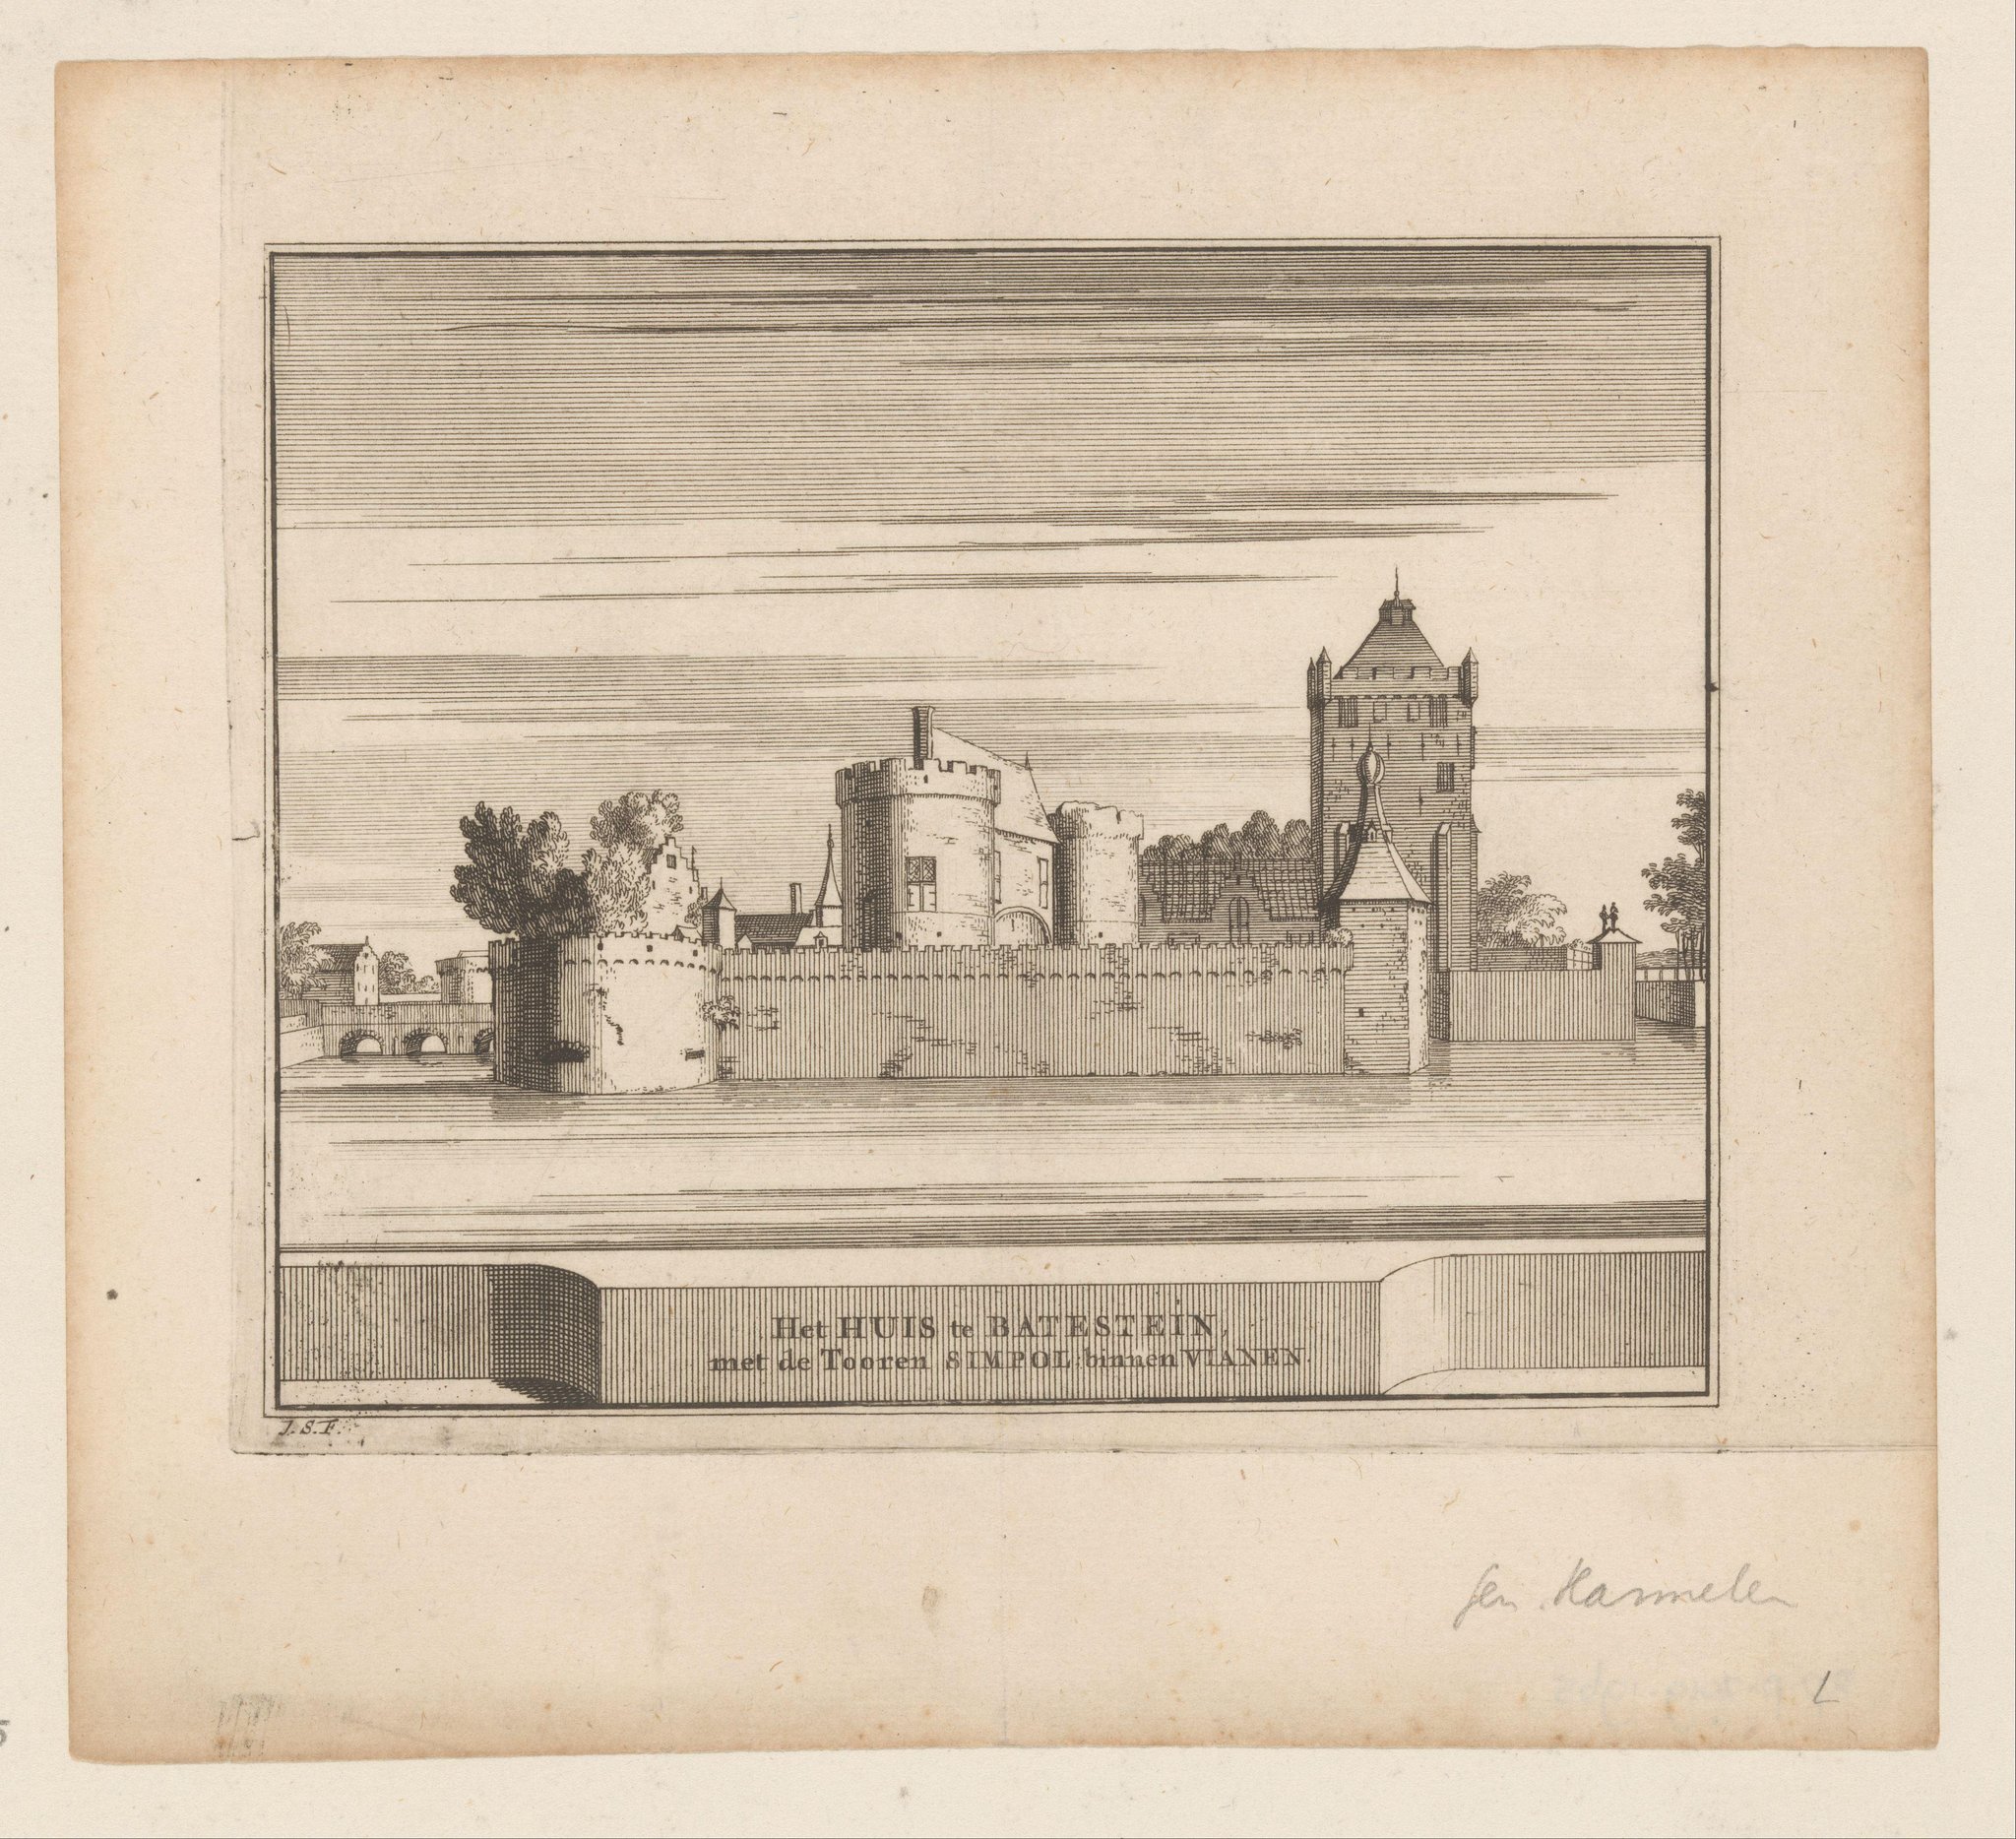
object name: print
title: Het huis te Batestein met de tooren Simpol, binnen Vianen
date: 1711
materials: paper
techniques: etching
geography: amsterdam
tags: castle, landscape with tower or castle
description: Prent uit: Smids, Ludolph. Schatkamer der Nederlandsse oudheden (...). Amsterdam: Pieter de Coup, 1711, p. 28-29. Ook uitgegeven in de latere edities (1737 en 1774), even als in het in 1721 uitgegeven werk dat alleen de platen van dit boek bevat: Nederlandsche oudheden, bestaande in zestig verbeeldingen (...). Amsterdam: Hendrik Bosch, 1721.